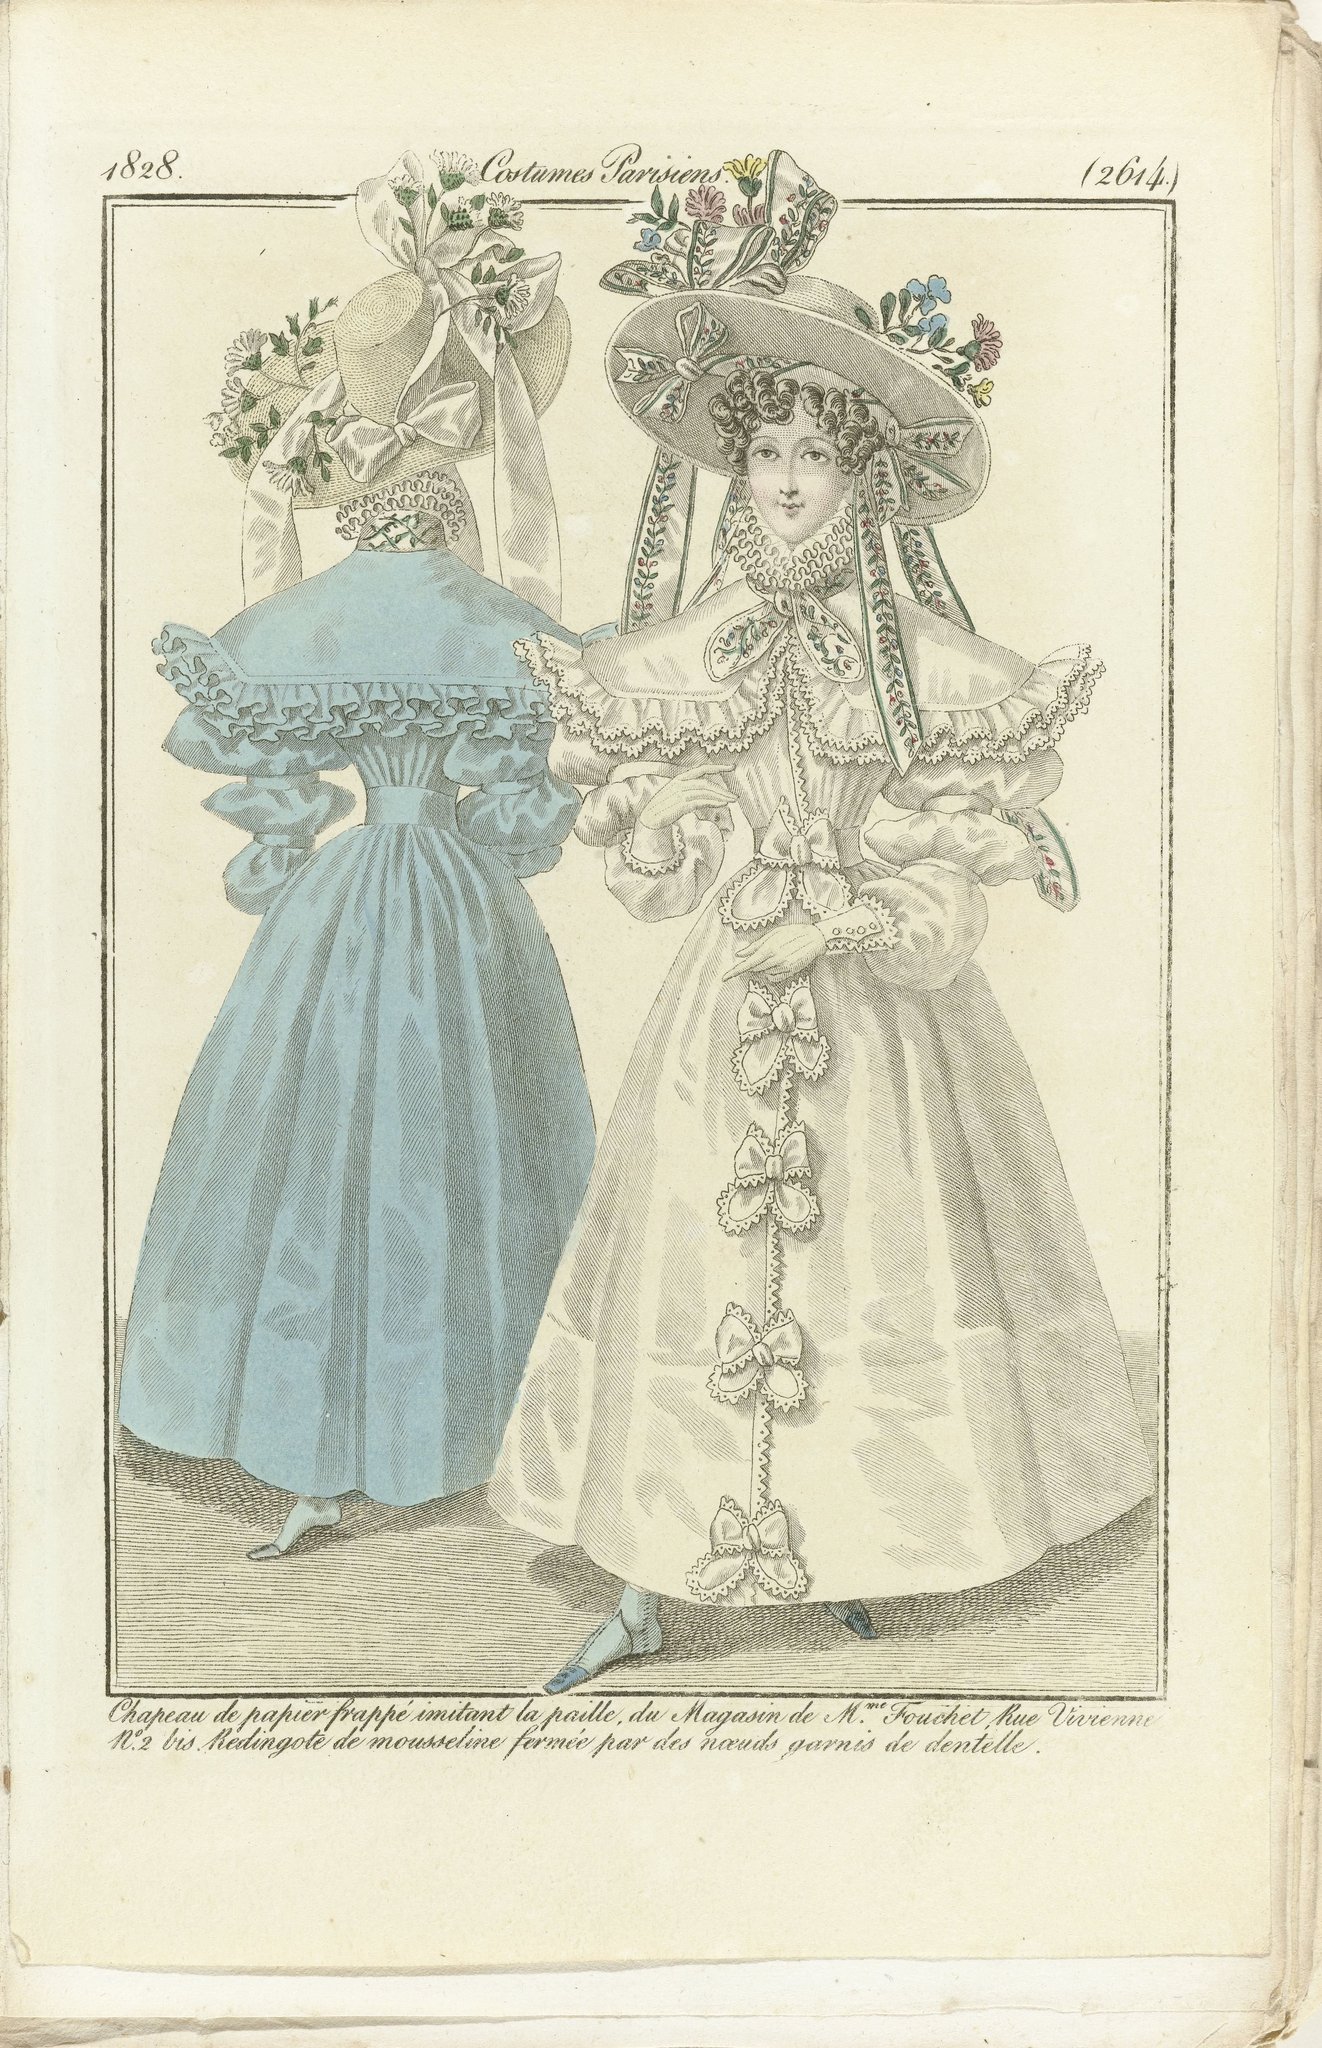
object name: fashion print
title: Journal des Dames et des Modes 1828, Costumes Parisiens (2614)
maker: Anonymous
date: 1828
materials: paper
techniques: etching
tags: fashion plates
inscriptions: date